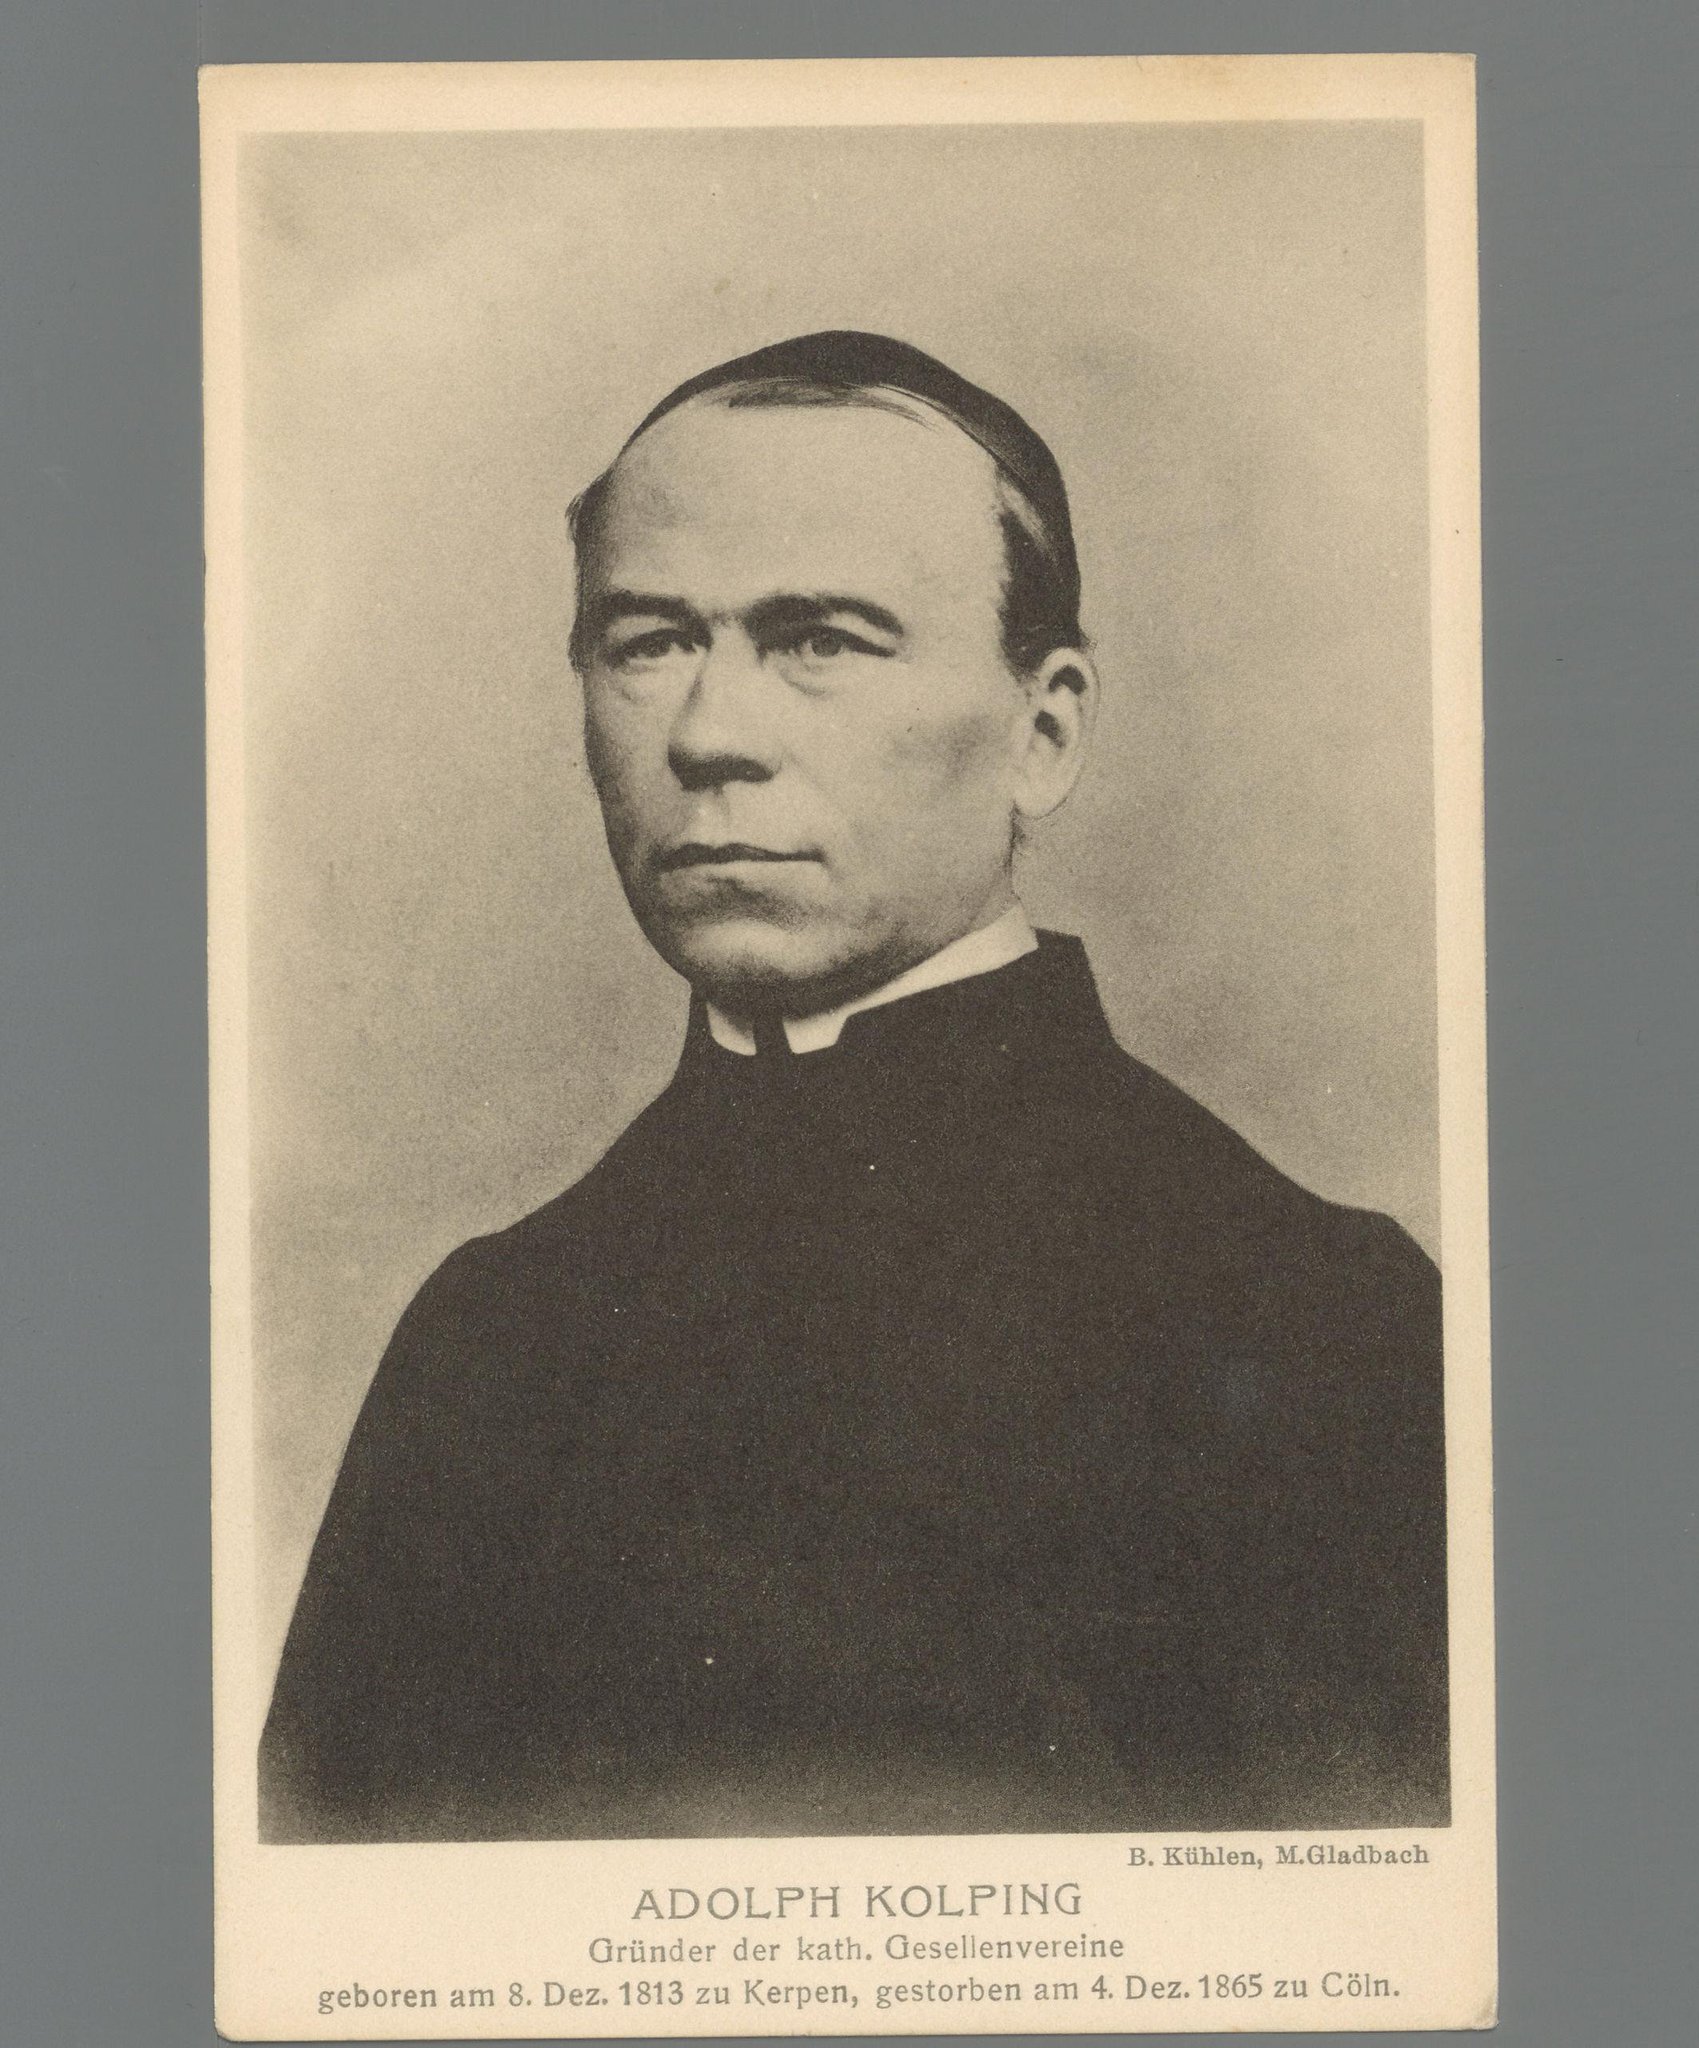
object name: ansichtkaart, prentbriefkaart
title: Adolph Kolping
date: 1905-1930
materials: cardboard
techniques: photograph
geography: cologne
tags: cologne, priest ~ roman religion, historical persons